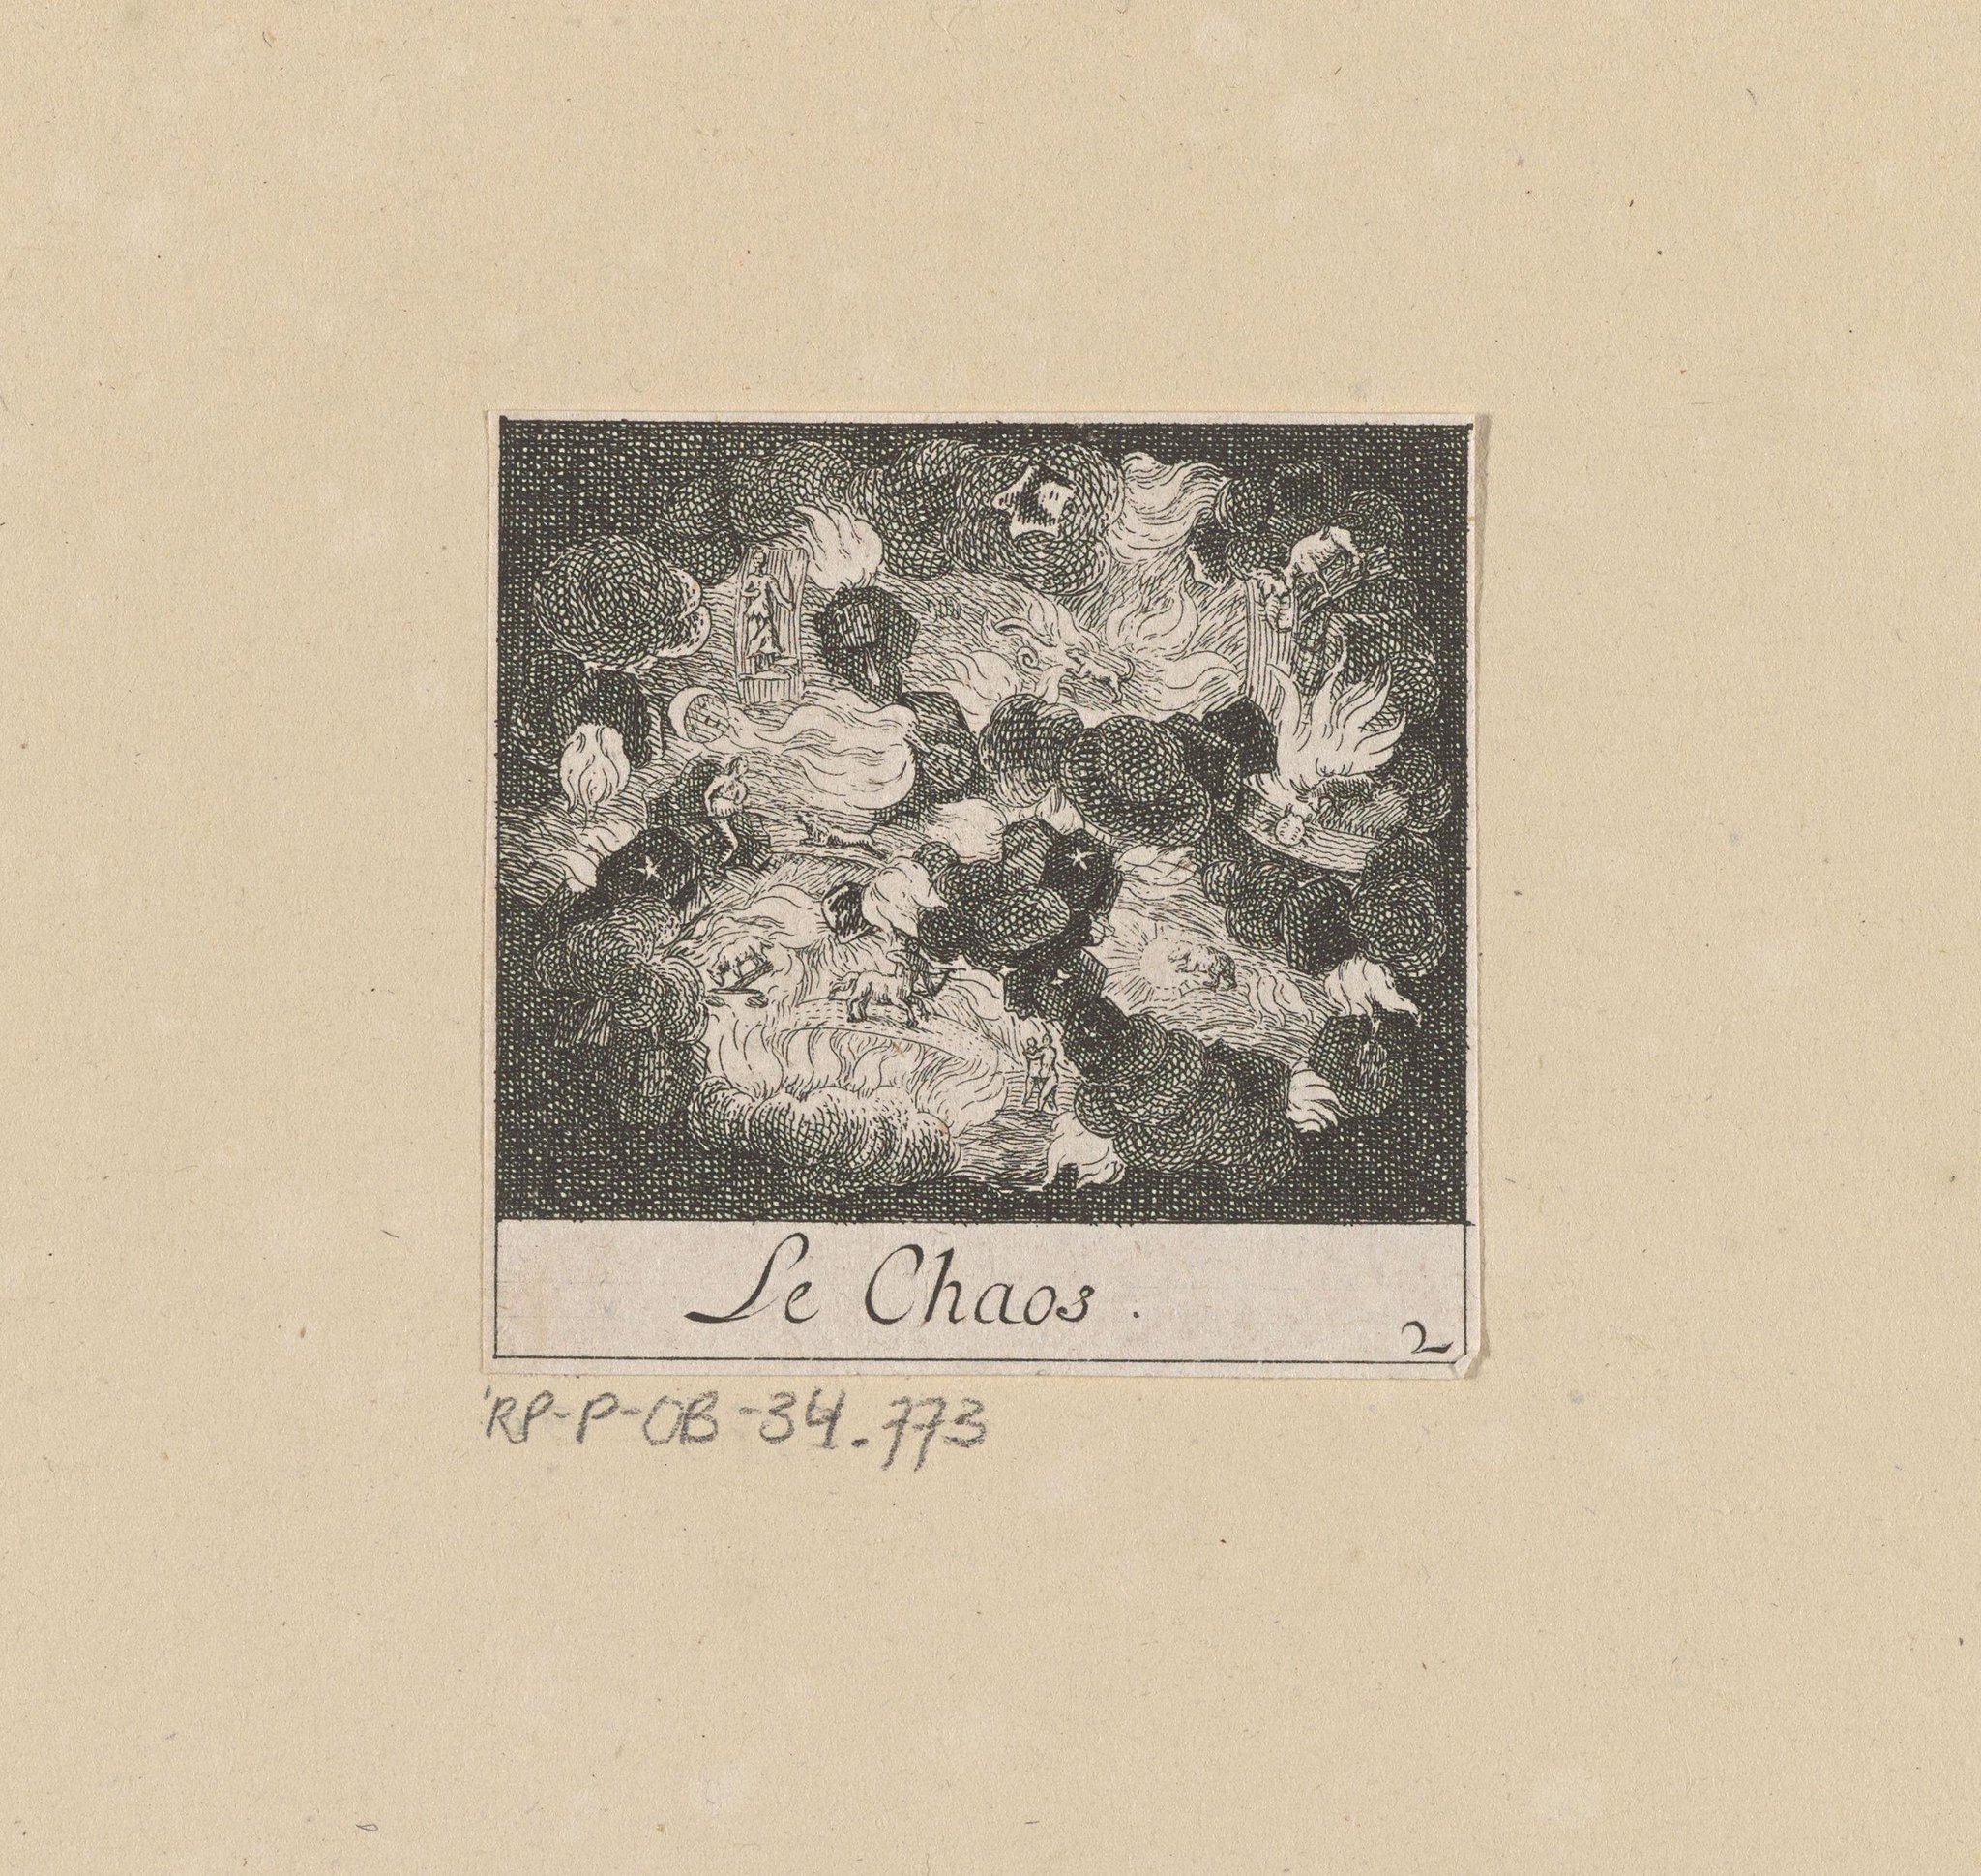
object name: playing card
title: Le Chaos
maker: Anonymous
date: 1620-1664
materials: paper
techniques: etching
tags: genesis of the universe ~ classical mythology, other primeval deities: chaos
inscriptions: collector's mark: Lugt 240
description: Prent uit een reeks van 54 genummerde speelkaarten met voorstellingen uit de Metamorfosen van Ovidius.